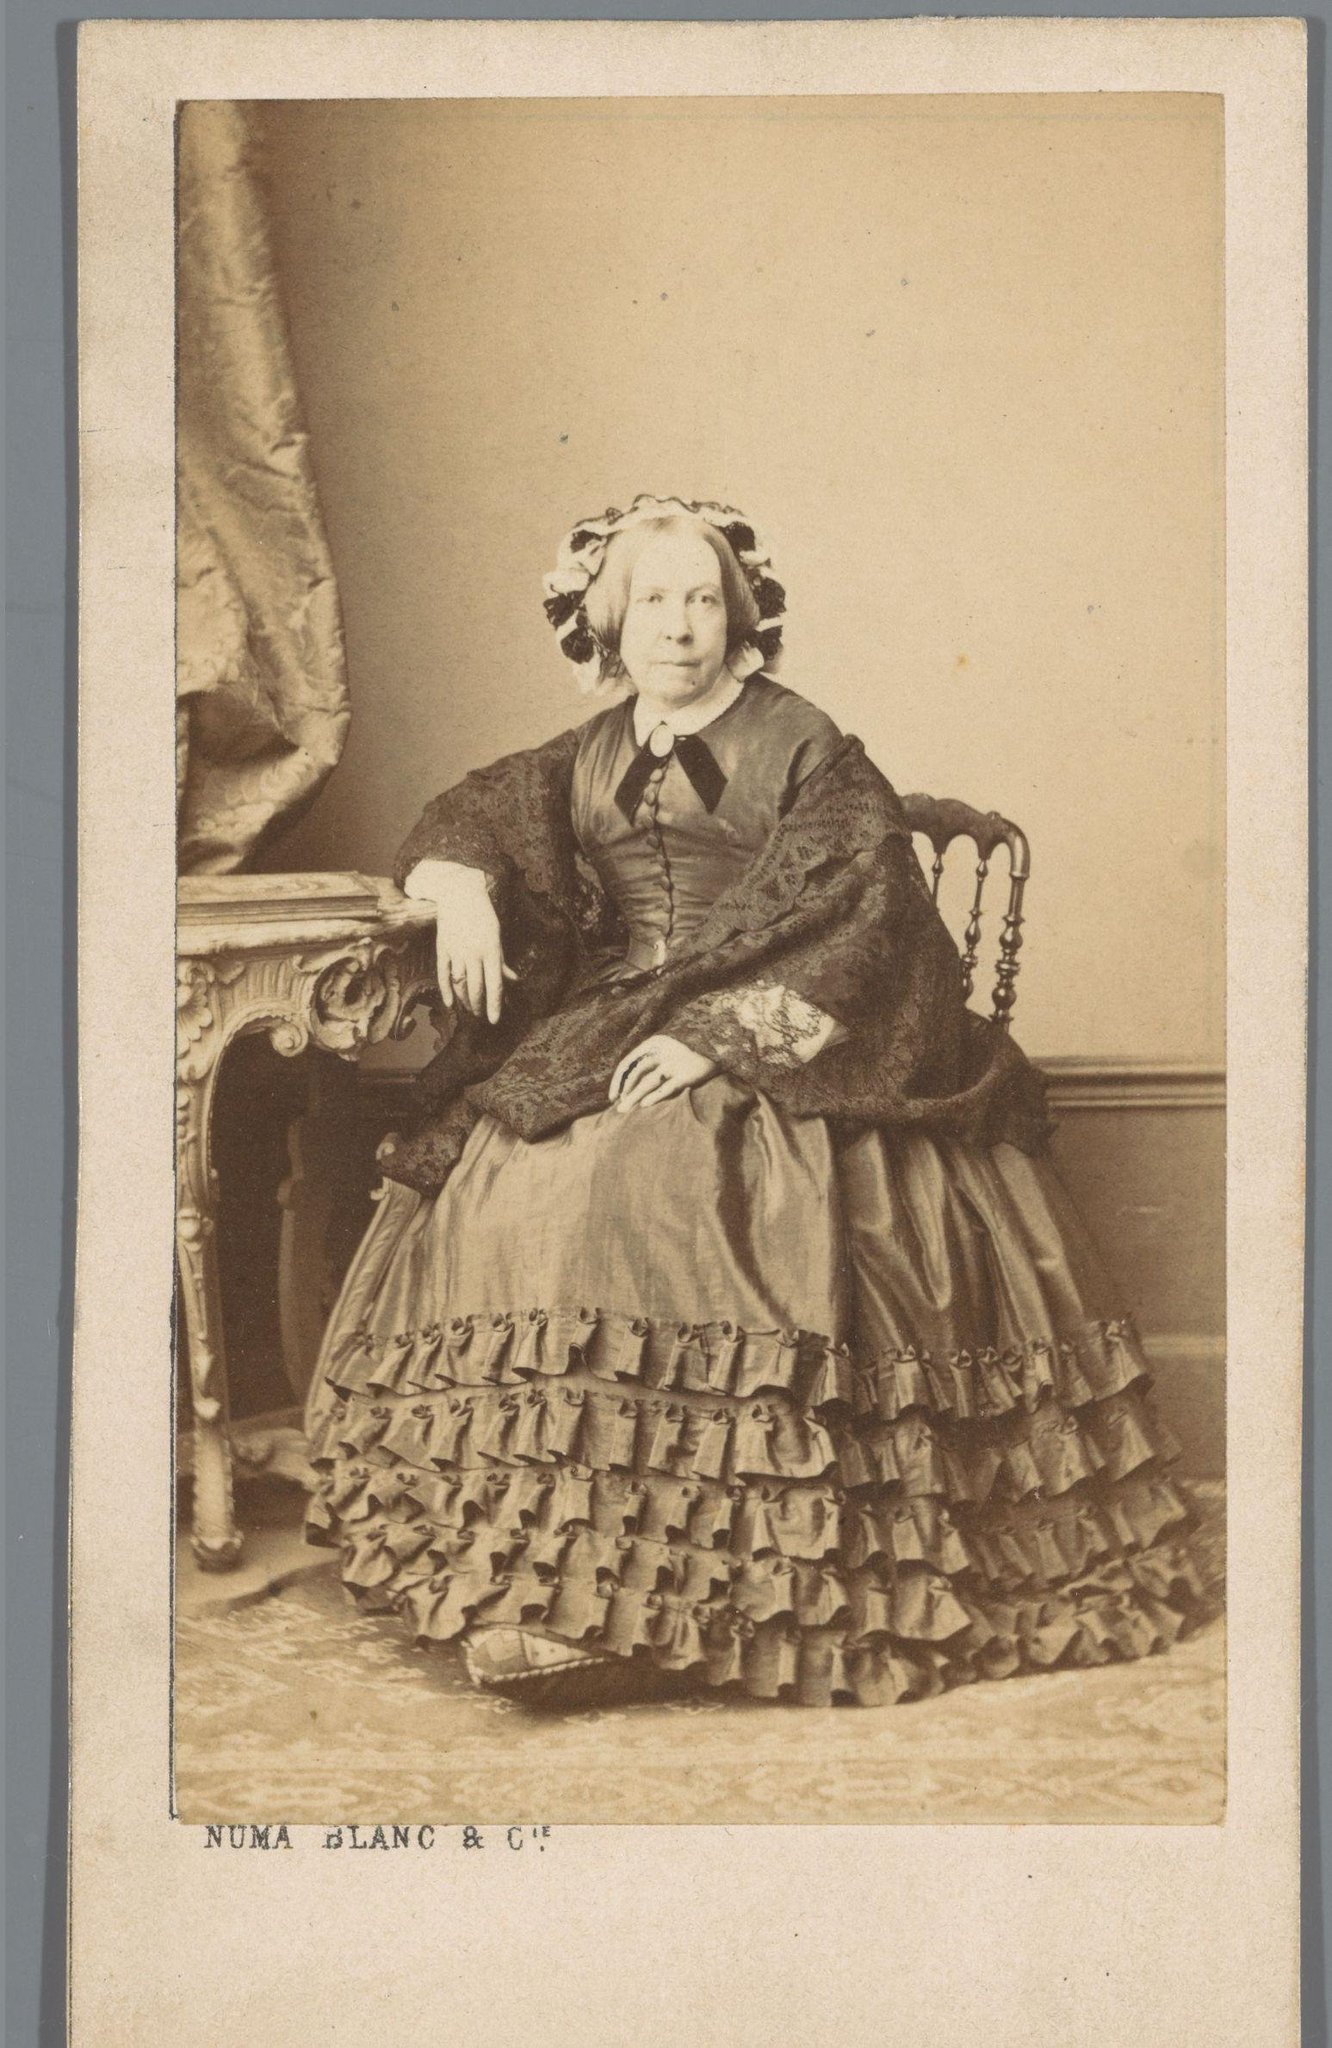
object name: carte de visite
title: Portret van een onbekende vrouw, zittend aan tafel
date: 1858-1865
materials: cardboard, paper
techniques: albumen print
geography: paris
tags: sitting figure, historical persons - bb - woman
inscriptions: inscription: ‘MÉDAILLE D'OR/ (...) 1858 (...)/ NUMA BLANC & CIE./ PHOTOGRAPHES./ BREVETÉS S.G.D.G./ 29, Boulevard des Italiens/ PARIS.’